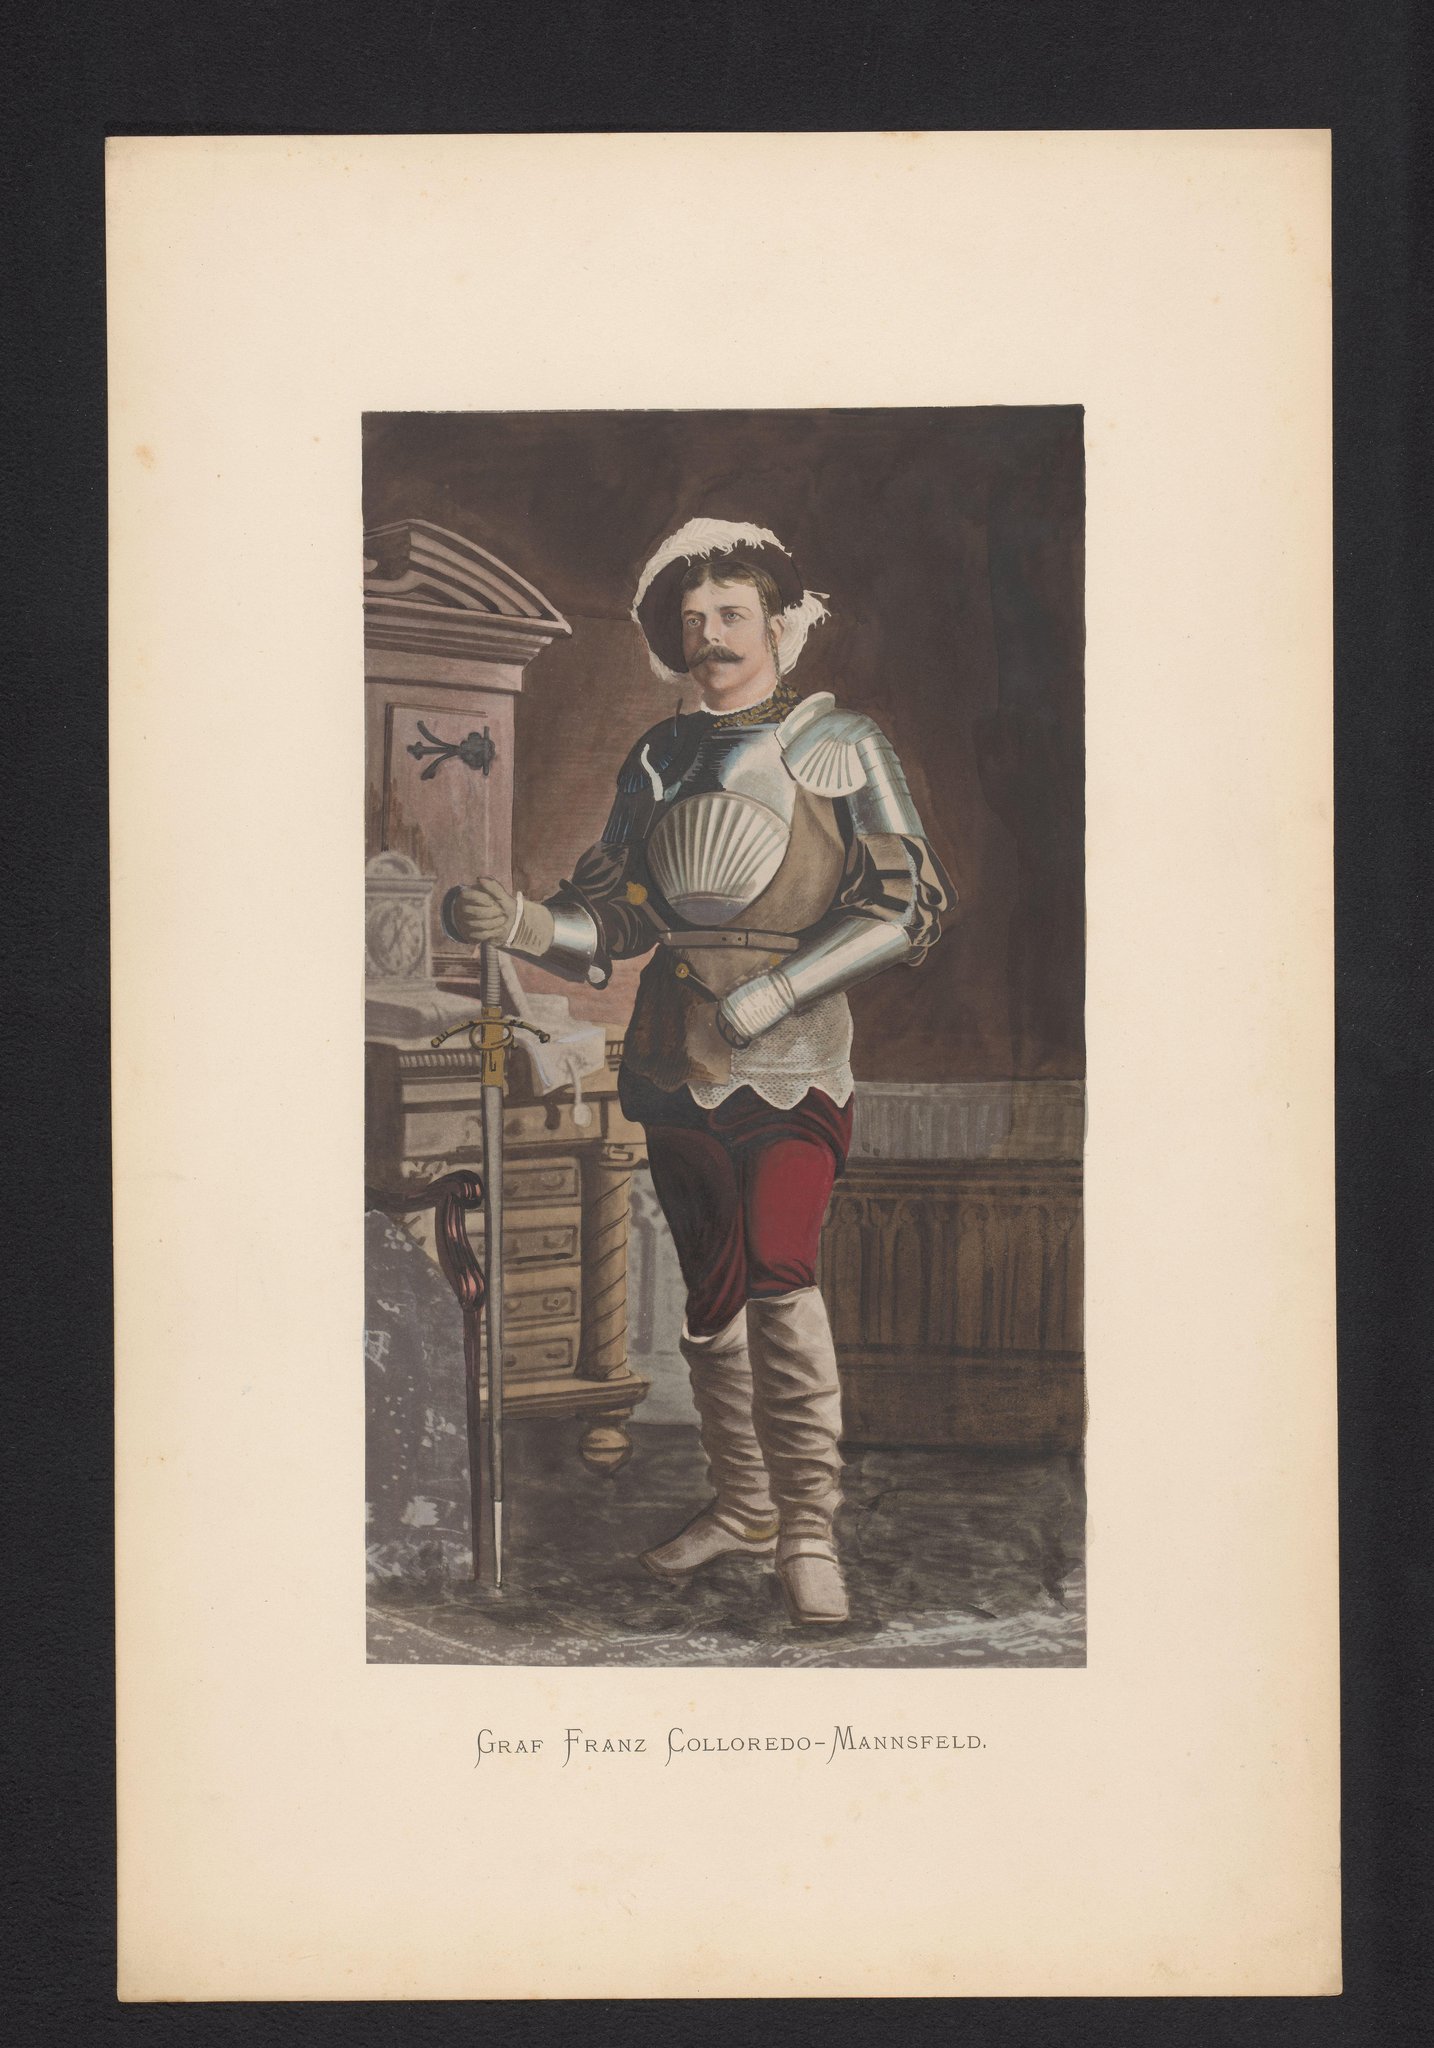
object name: photomechanical print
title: Graf Franz Colloredo-Mannsfeld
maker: Anonymous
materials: paper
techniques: photograph, hand coloring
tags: aristocracy; 'aristocratia' (ripa), historical persons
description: Deze prent maakt deel uit van een omslag met 86 prenten op 78 bladen en 11 tekstbladen.